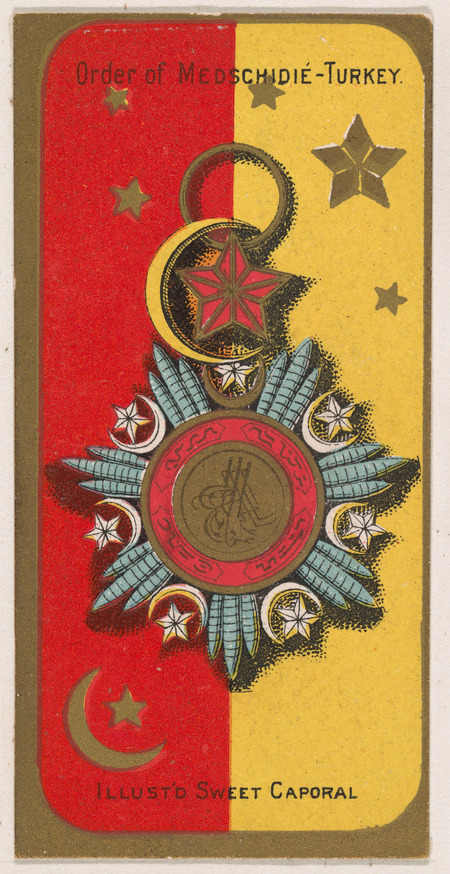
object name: print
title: Order of Medschidie, Turkey, from the Military Series (N224) issued by Kinney Tobacco Company to promote Sweet Caporal Cigarettes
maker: kinney brothers tobacco company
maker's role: publisher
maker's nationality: american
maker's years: 1869-2011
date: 1888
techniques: color lithograph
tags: insignia